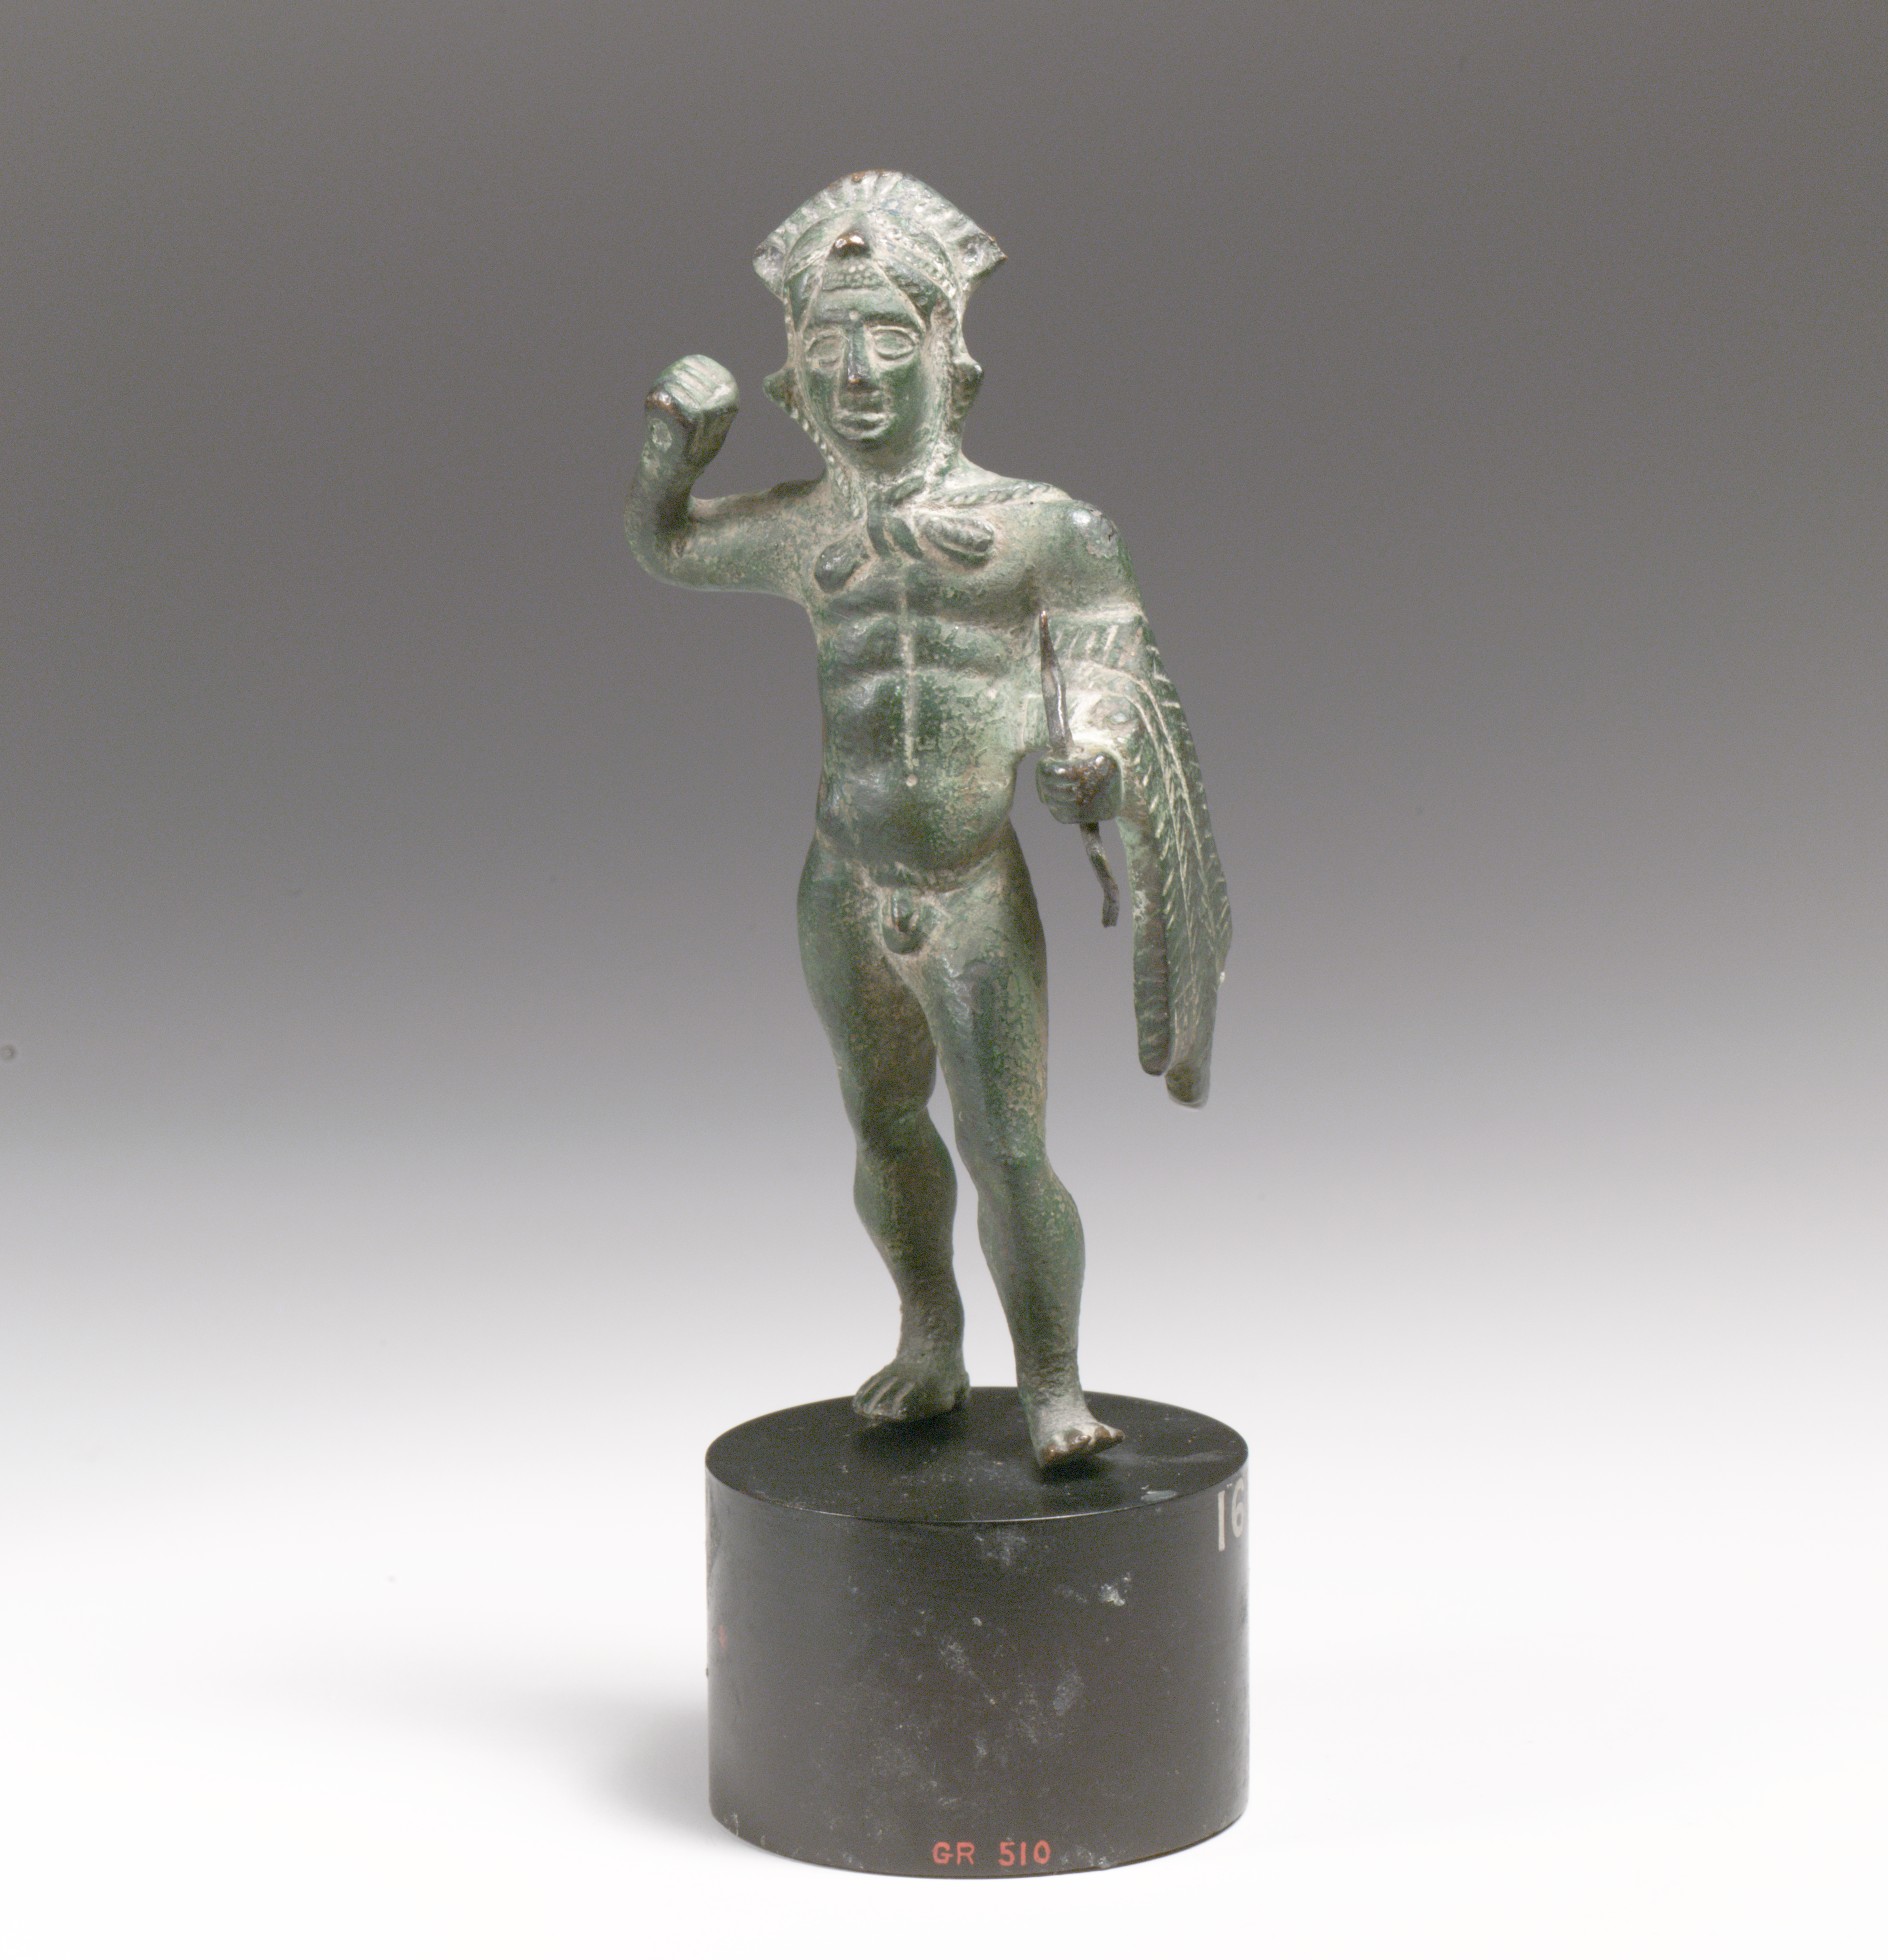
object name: statuette of herakles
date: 7000 BCE-330 CE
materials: bronze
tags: herakles